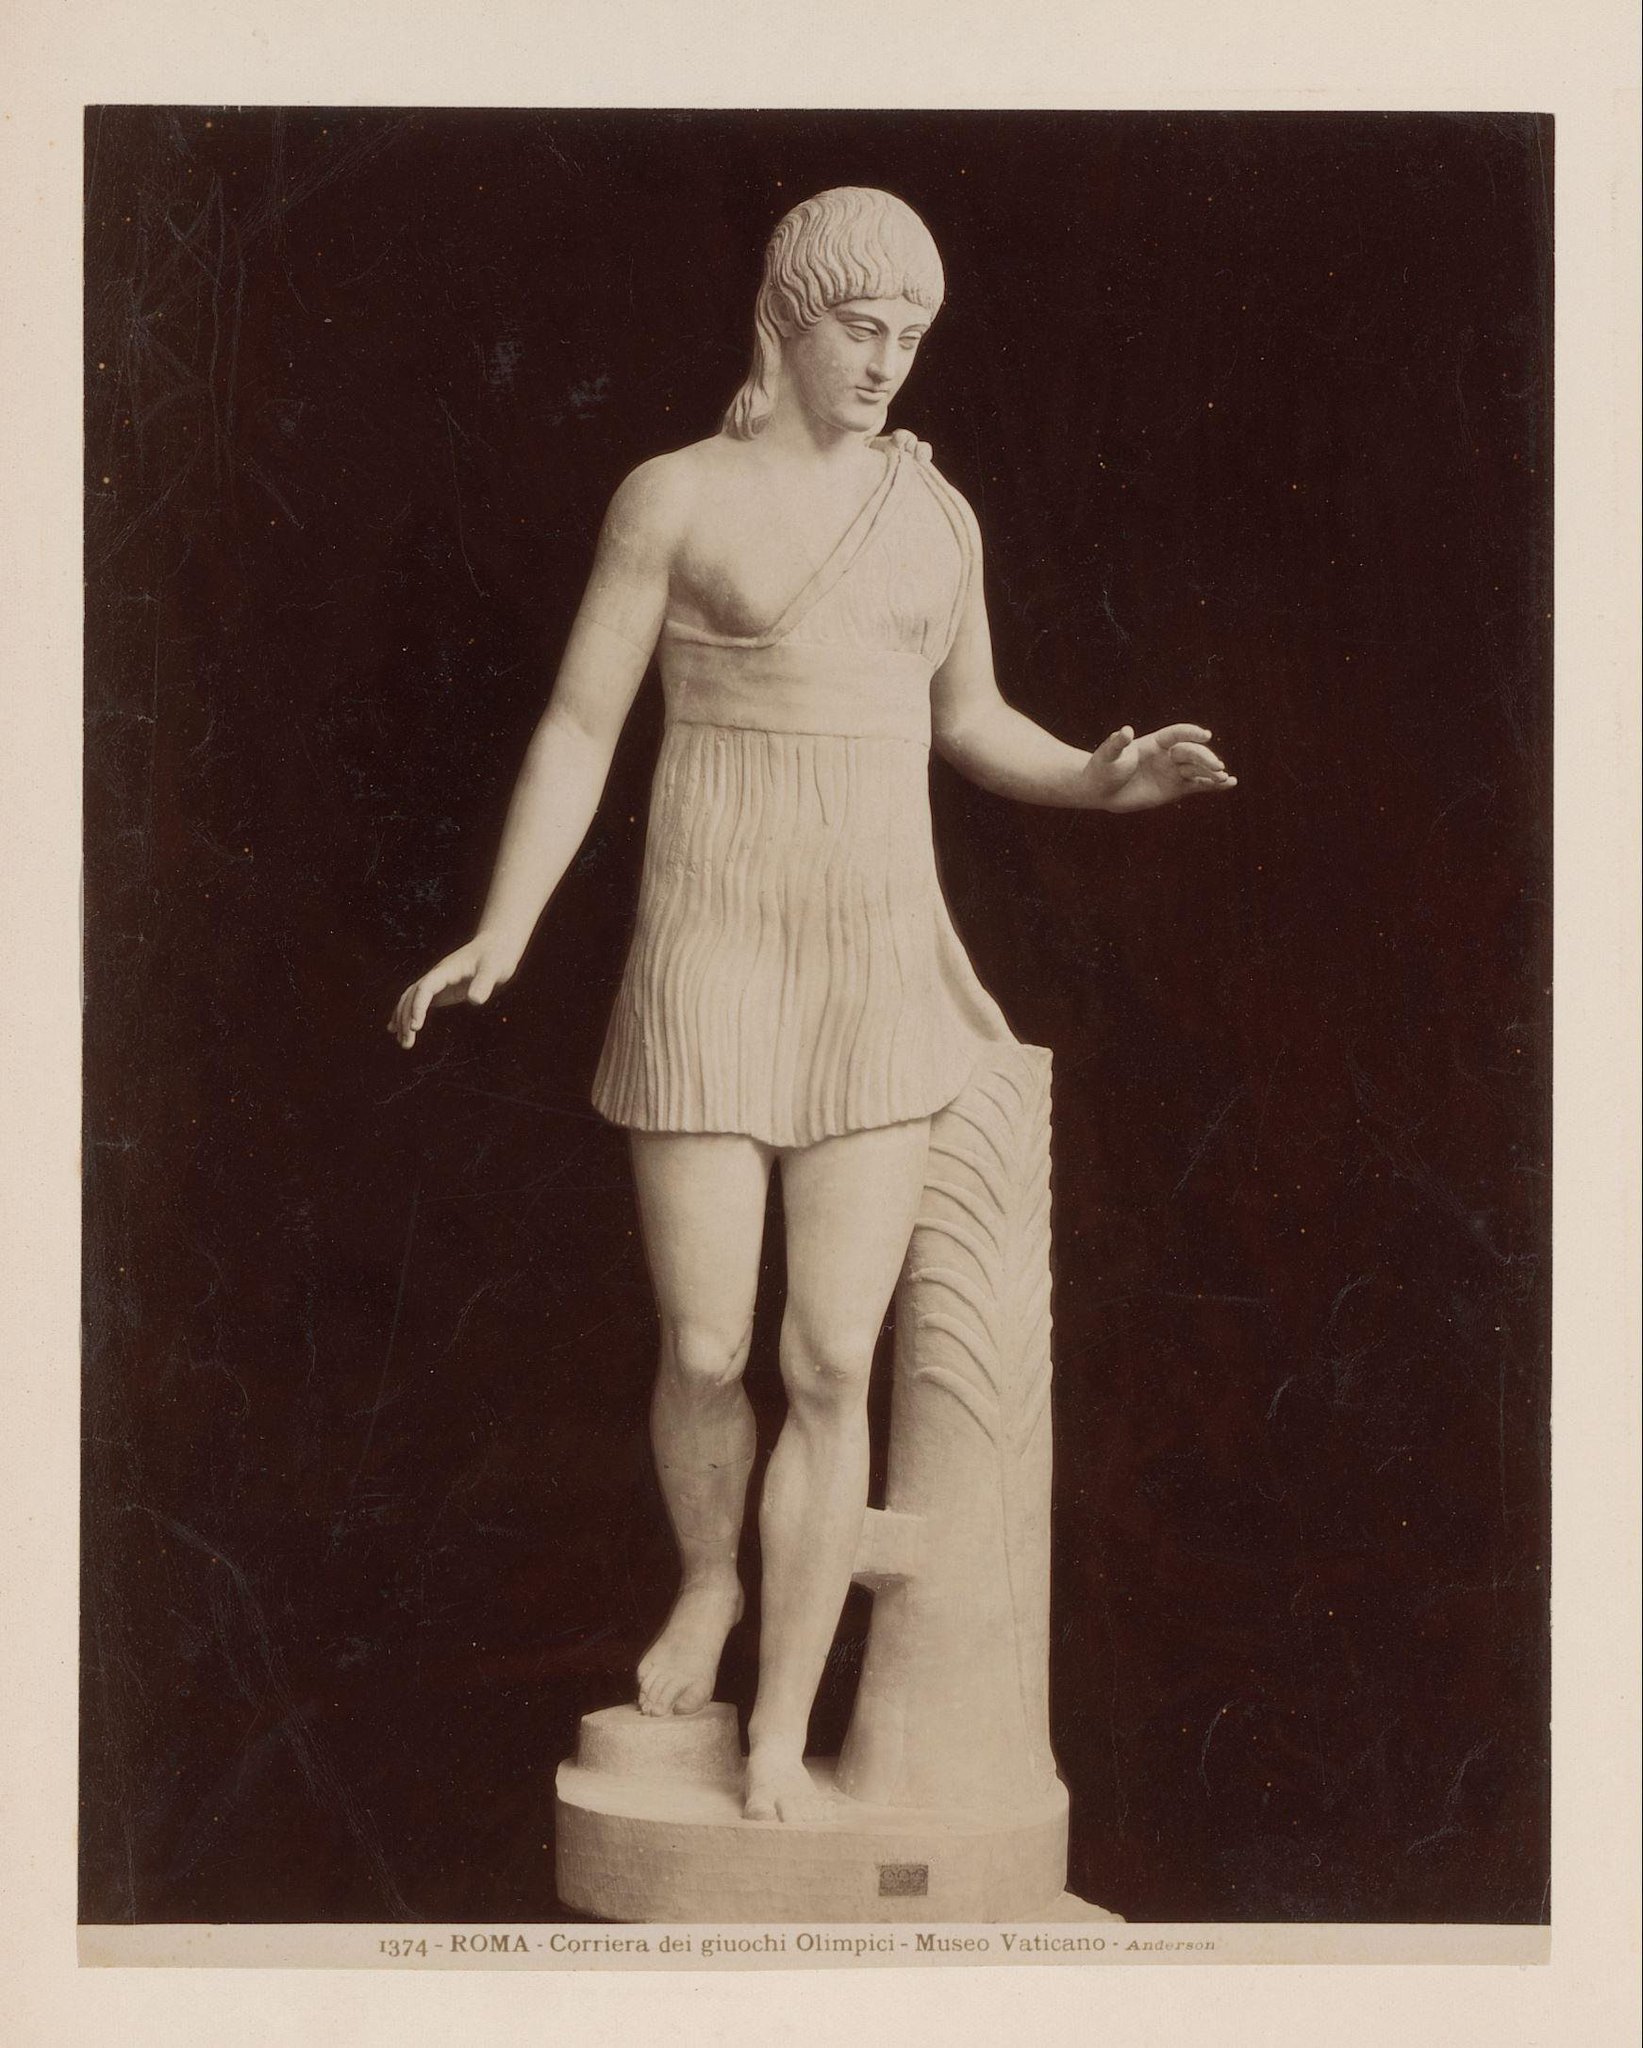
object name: photograph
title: Sculptuur van Atalanta, Vaticaan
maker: james anderson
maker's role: fotograaf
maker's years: 1813-1877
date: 1857-1875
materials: paper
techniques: albumen print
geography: vatican museums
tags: piece of sculpture, reproduction of a piece of sculpture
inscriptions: inscription: ‘1374 - ROMA - Corriera dei giuochi Olimpici - Museo Vaticano - Anderson’